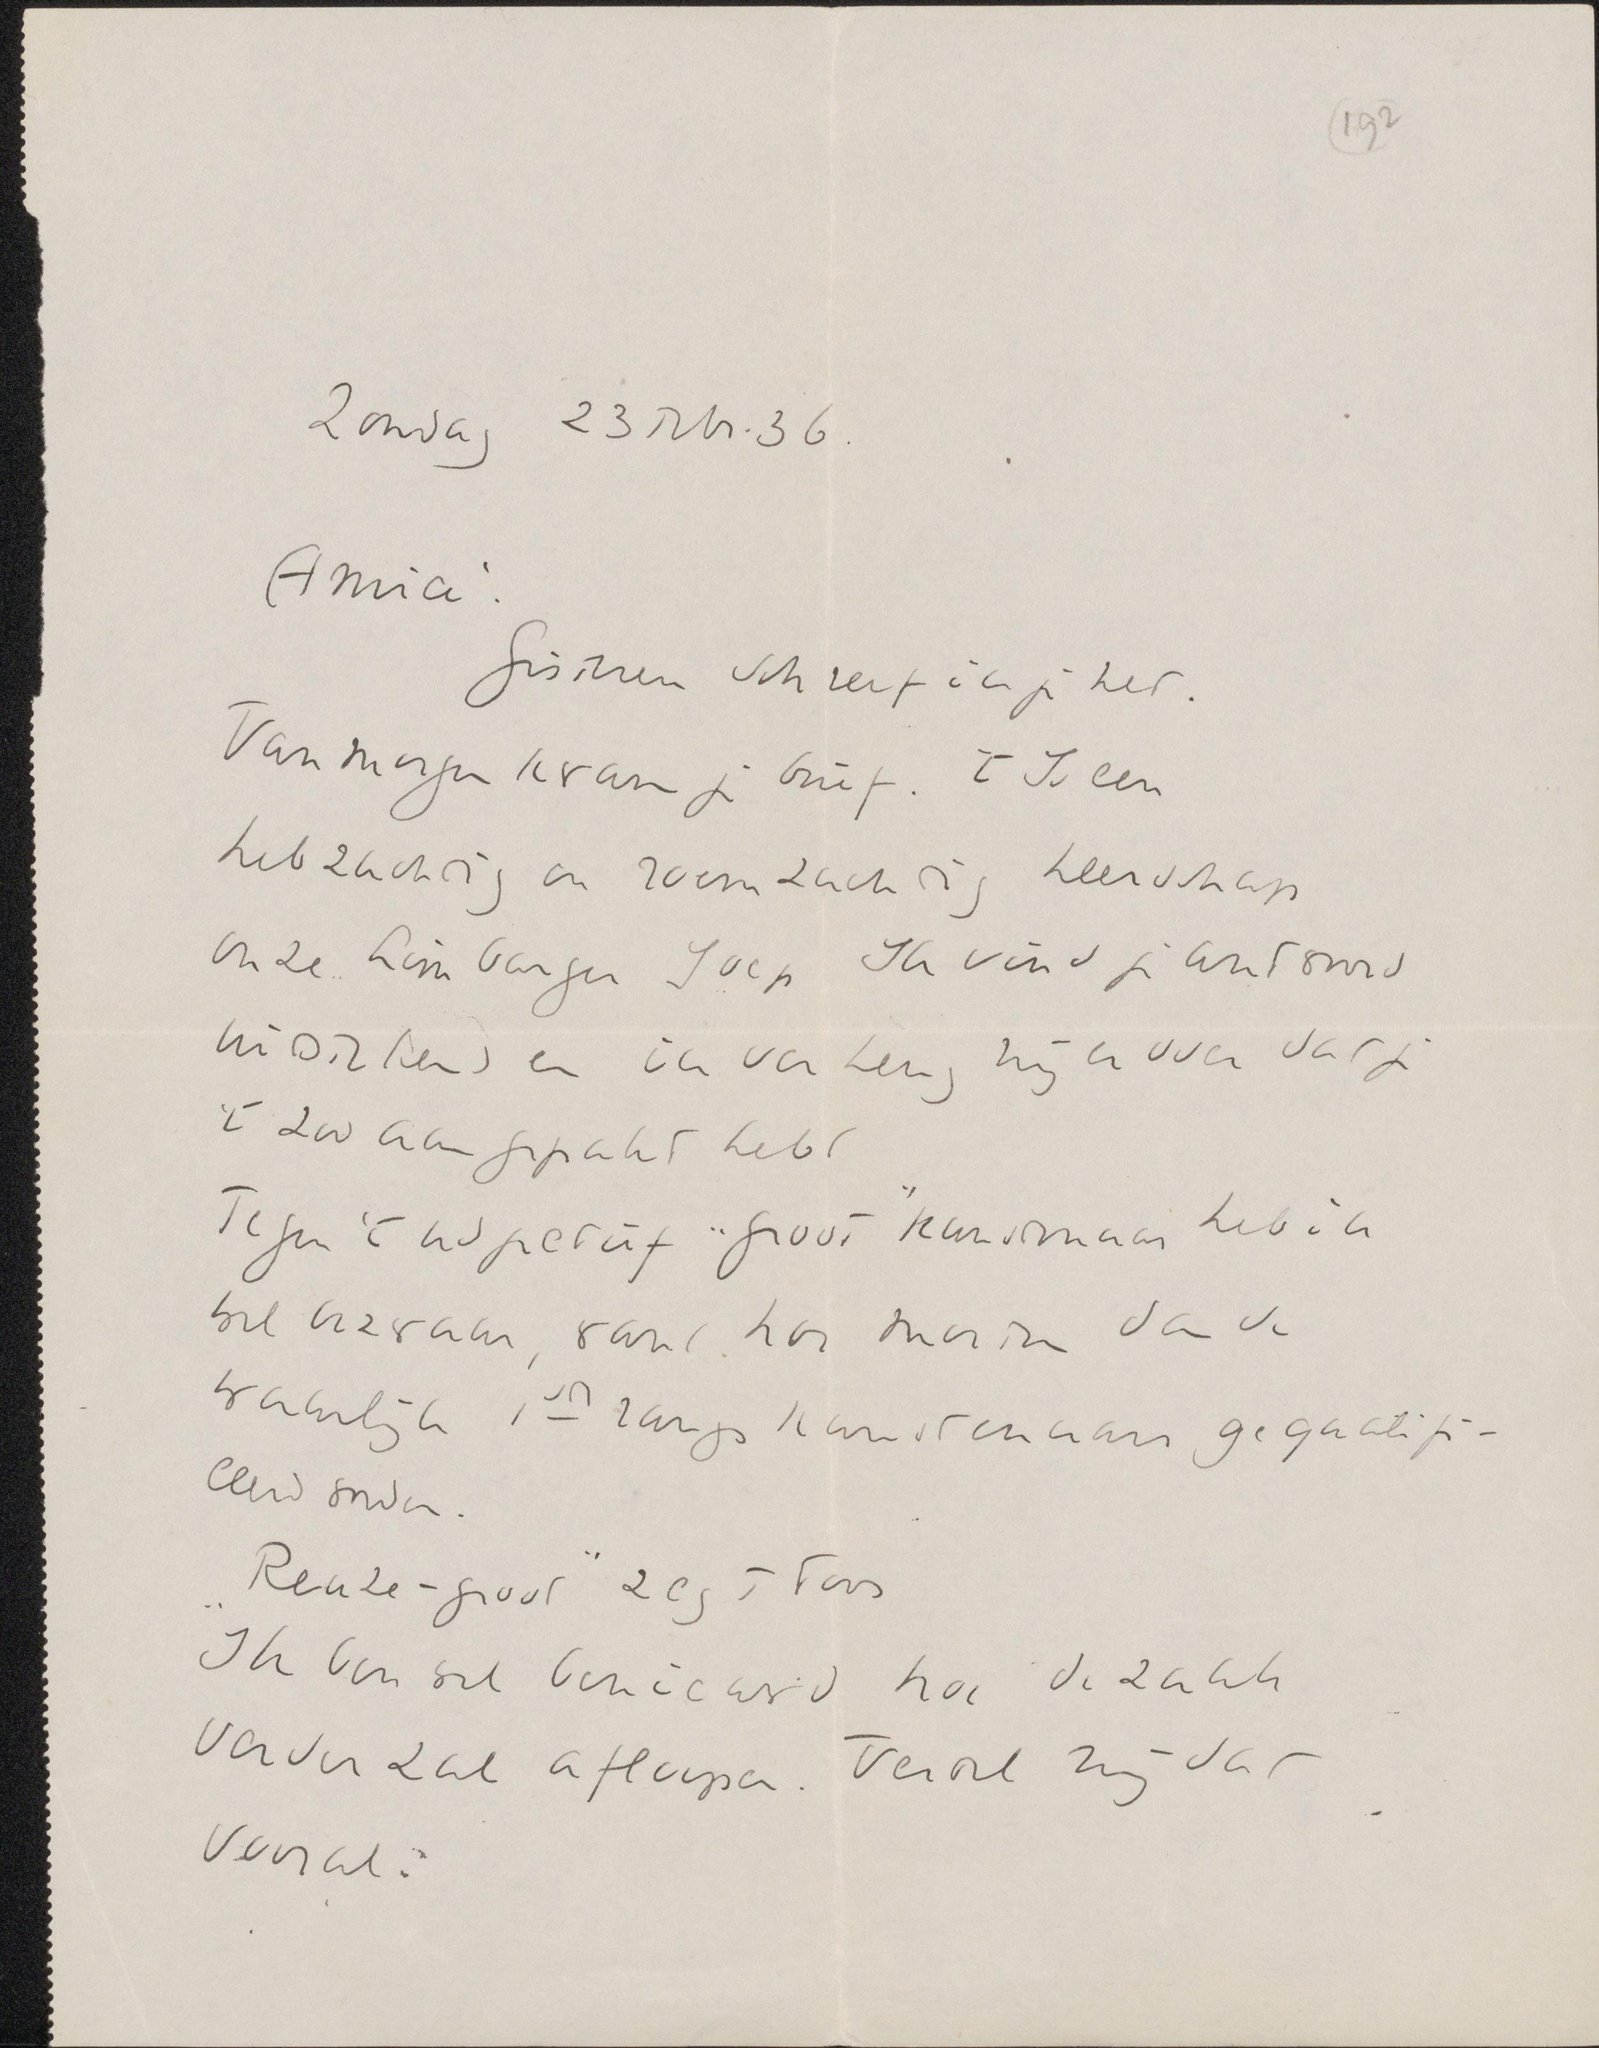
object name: letter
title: Brief aan Willem Bogtman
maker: richard nicolaüs roland holst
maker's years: 1868-1938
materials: ink, paper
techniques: pen, writing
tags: ab bogtman, toos bogtman, draughtsman, joep nicolas, haarlem, willem bogtman